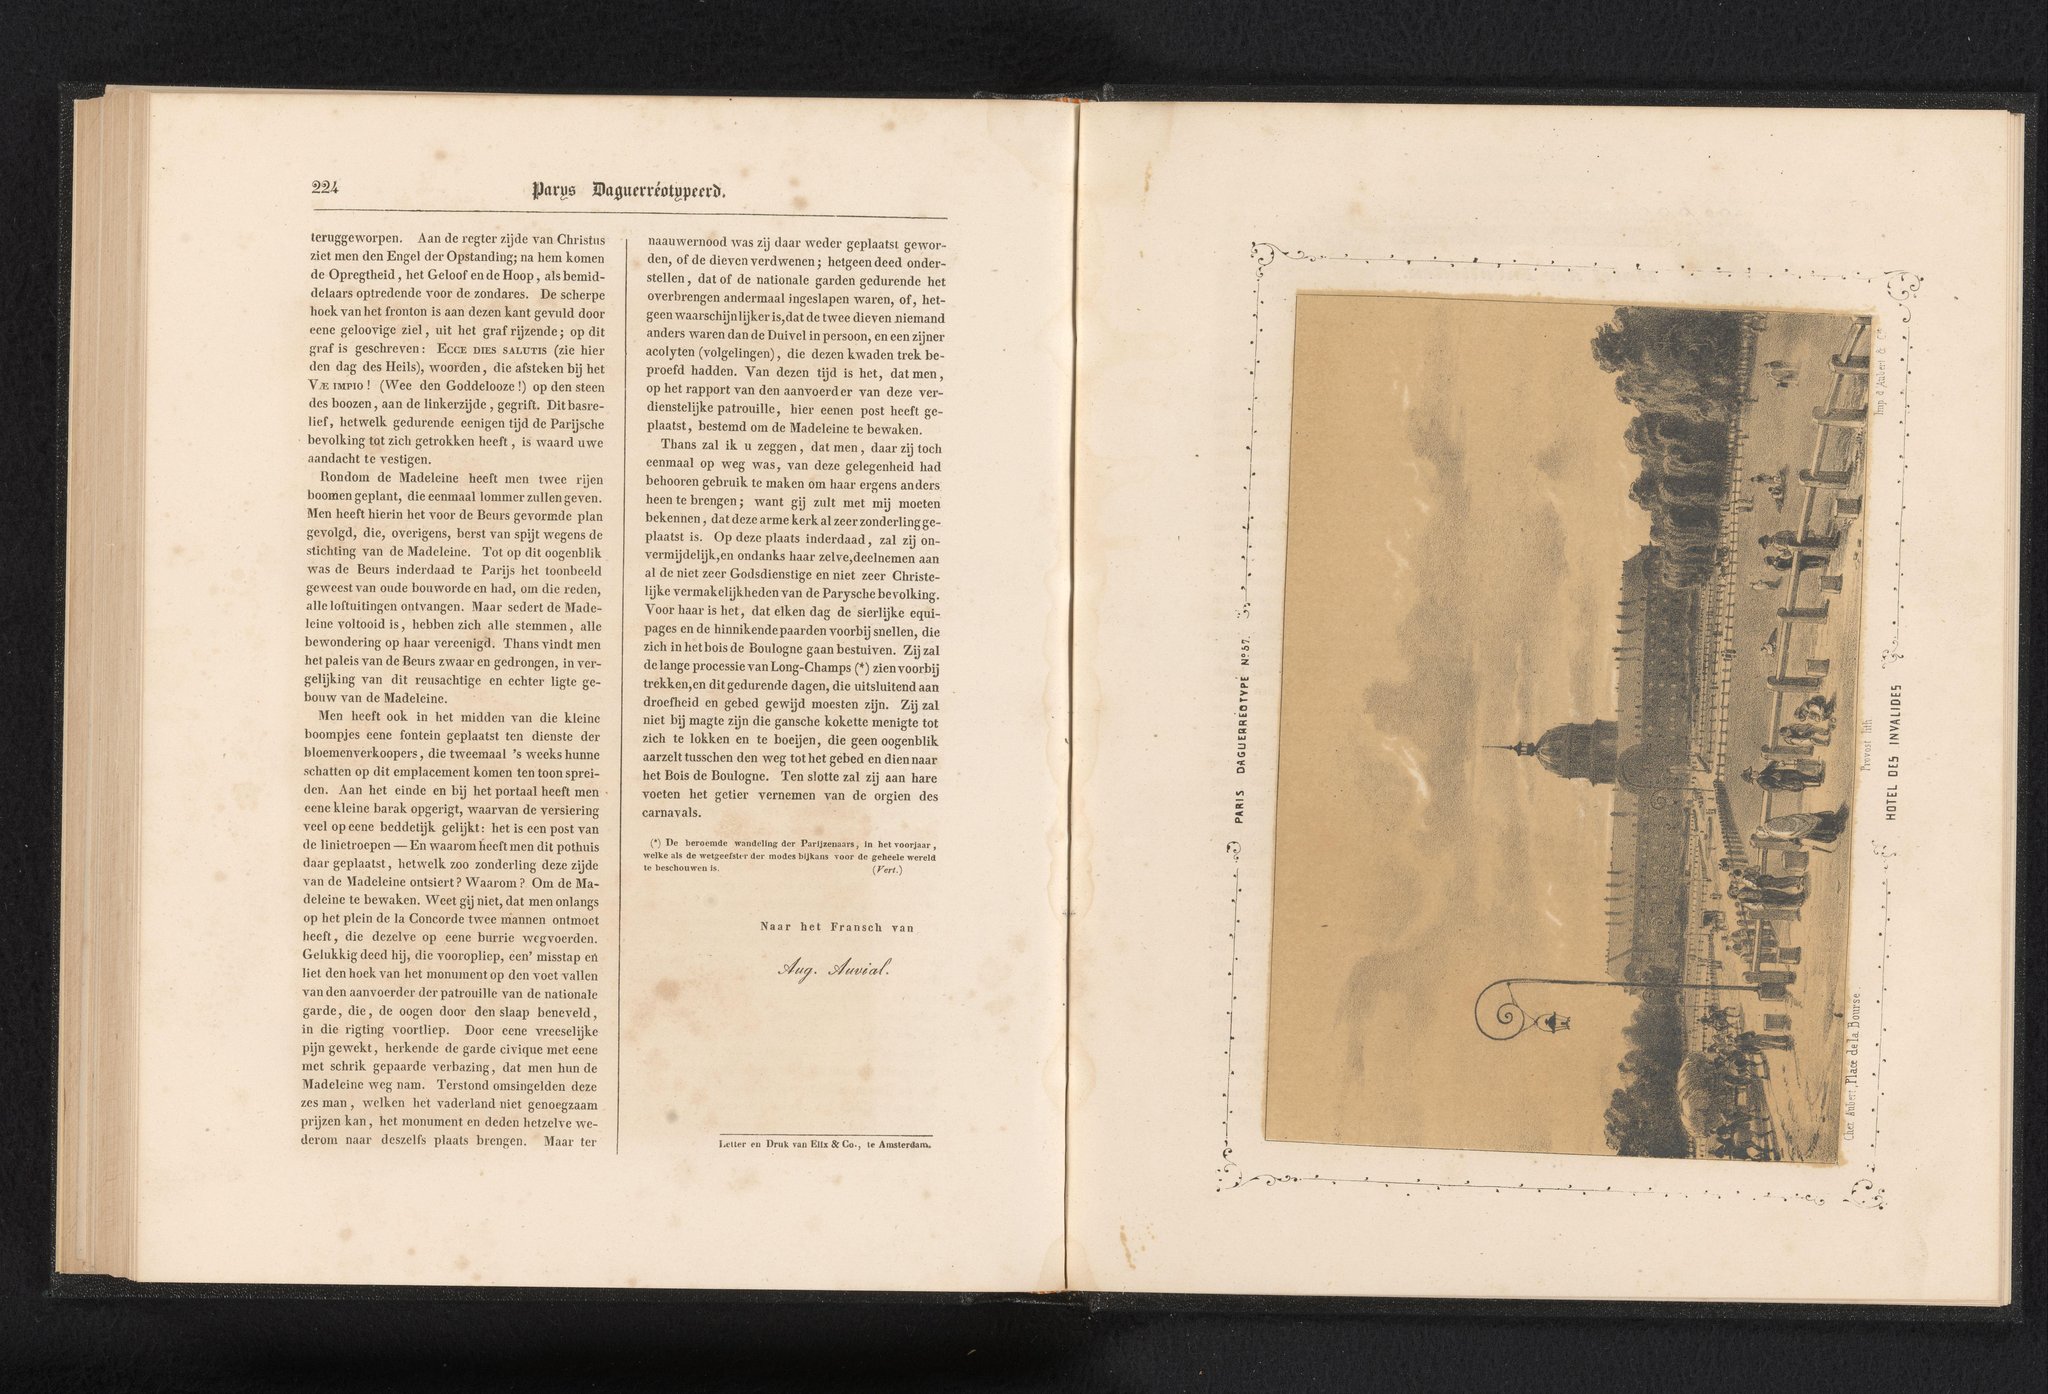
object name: page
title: Hôtel des Invalides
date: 1839-1840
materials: paper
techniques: tone lithography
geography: paris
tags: hospital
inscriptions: inscription: ‘PARIS DAGUERRÉOTYPÉ No. 57.’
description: Prent op tweehonderdzevenentwintigste ongenummerde pagina.